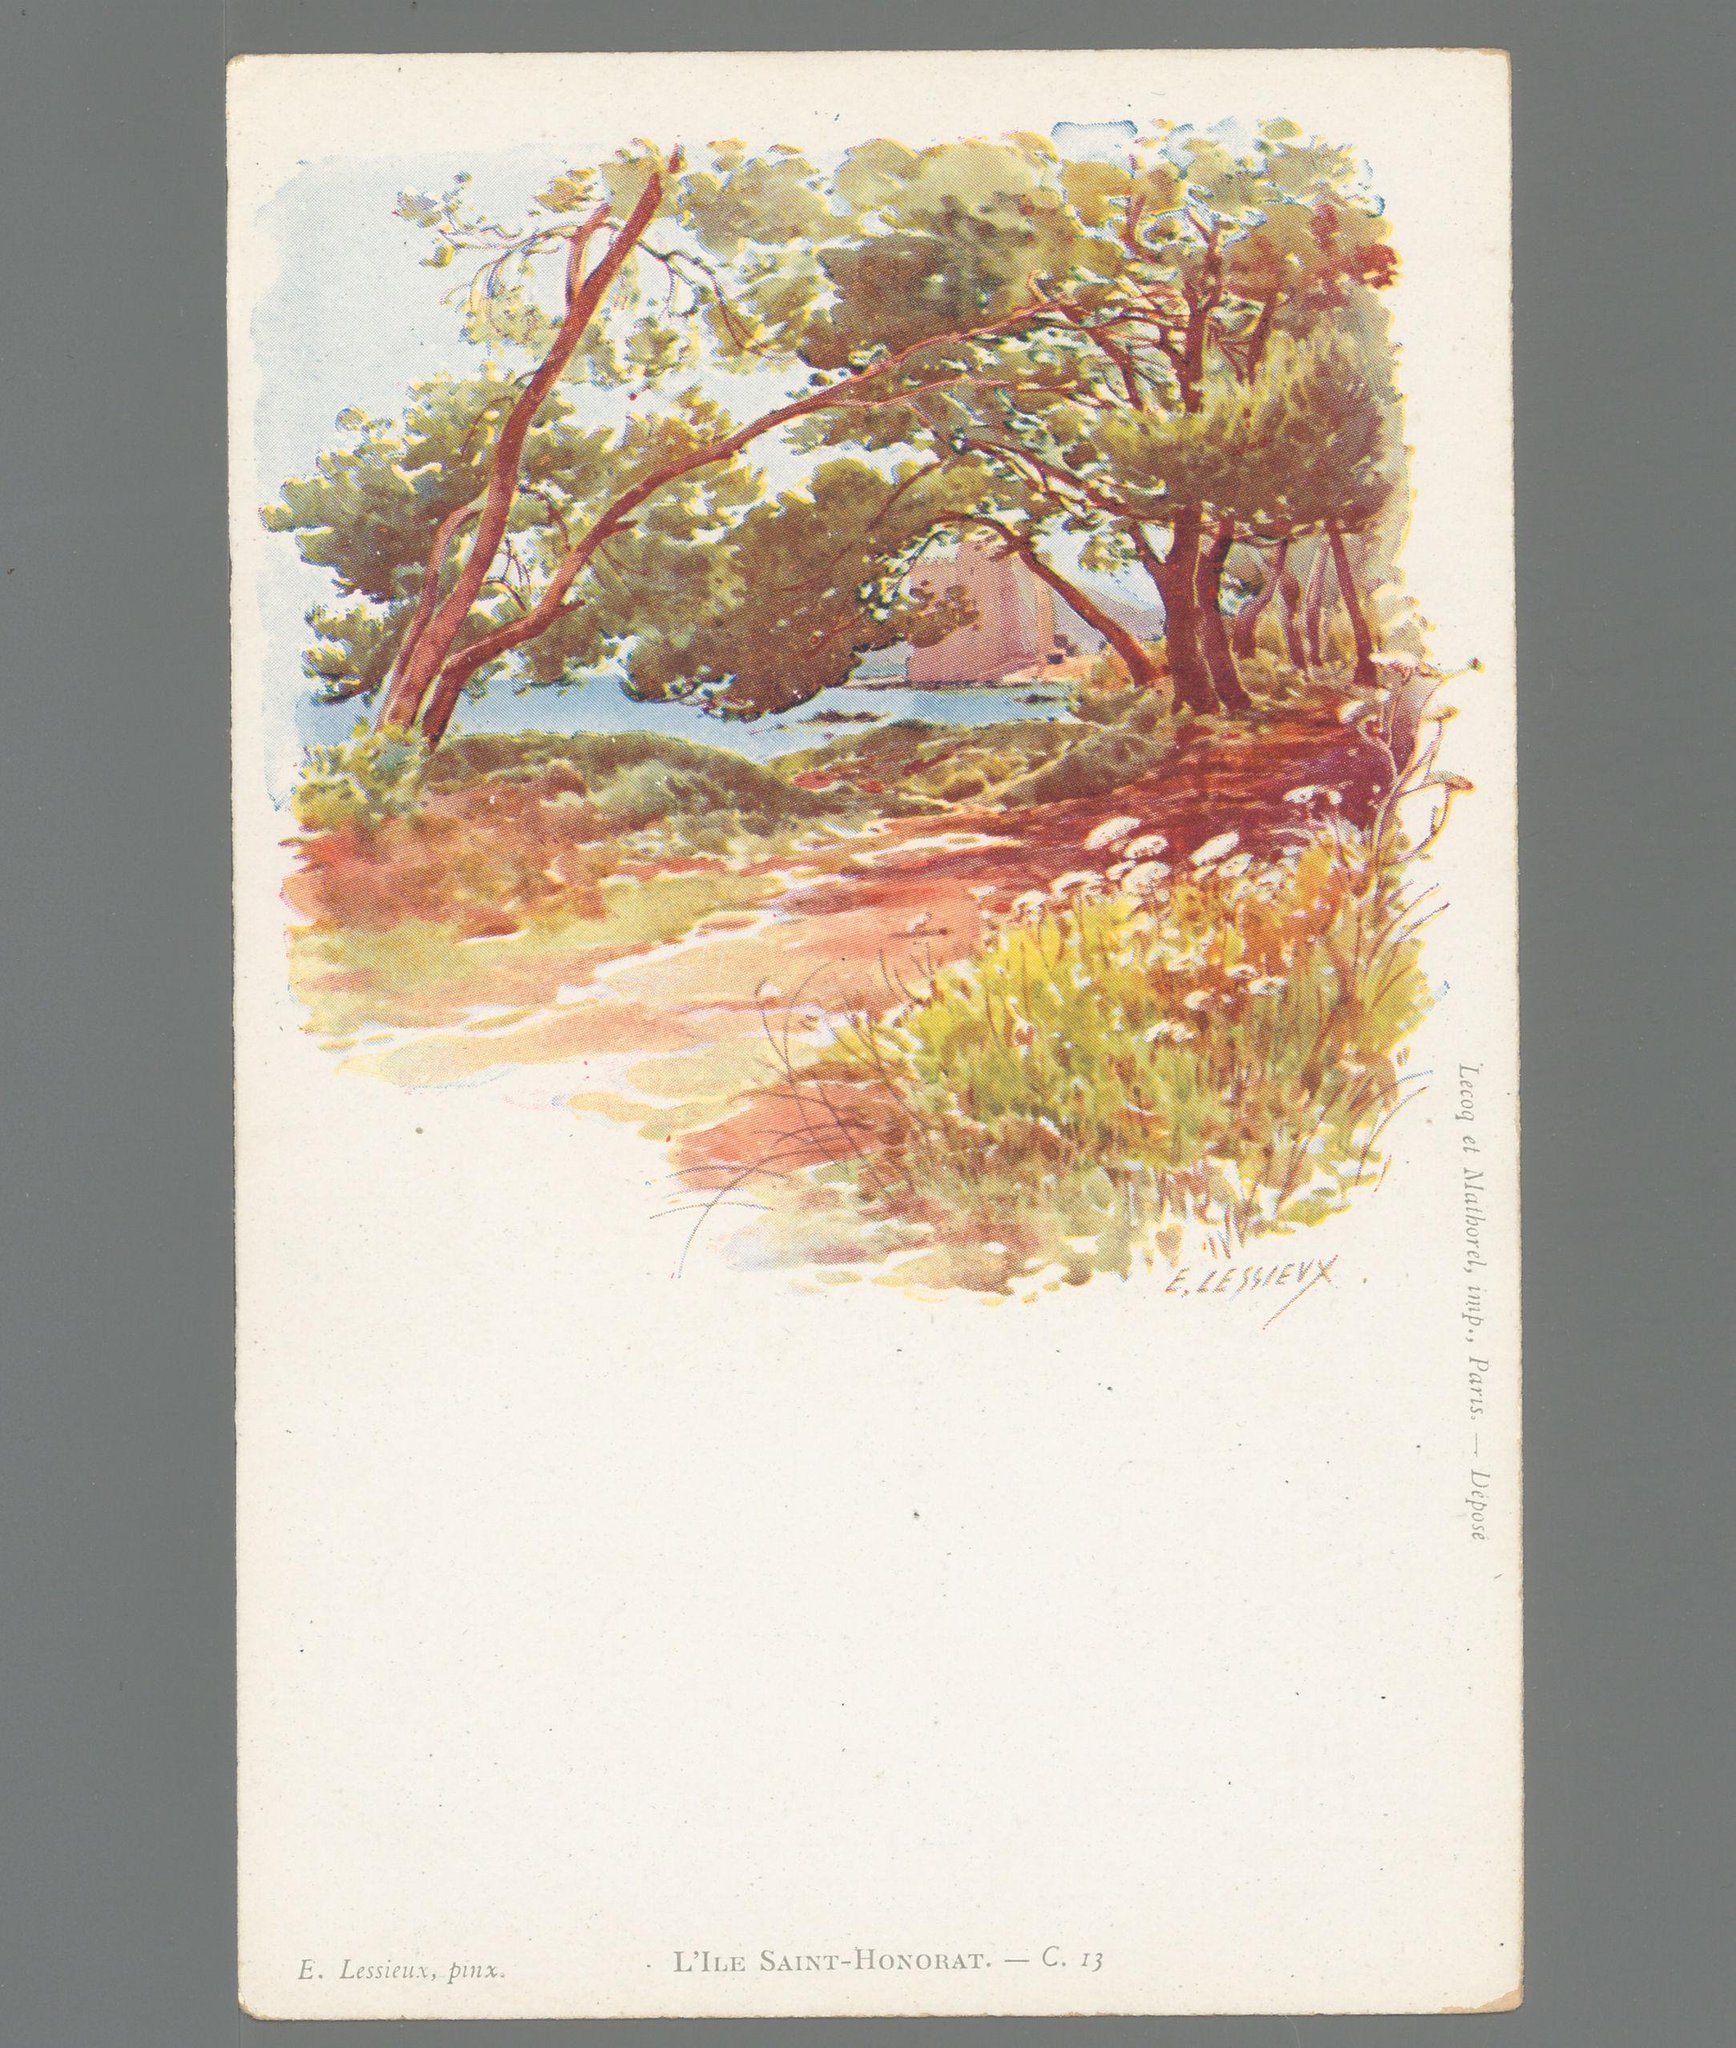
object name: photomechanical print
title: L'Ile Saint-Honorat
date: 1892-1904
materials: cardboard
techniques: photograph, writing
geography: paris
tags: trees, landscapes with waters, waterscapes, seascapes (in the temperate zone)